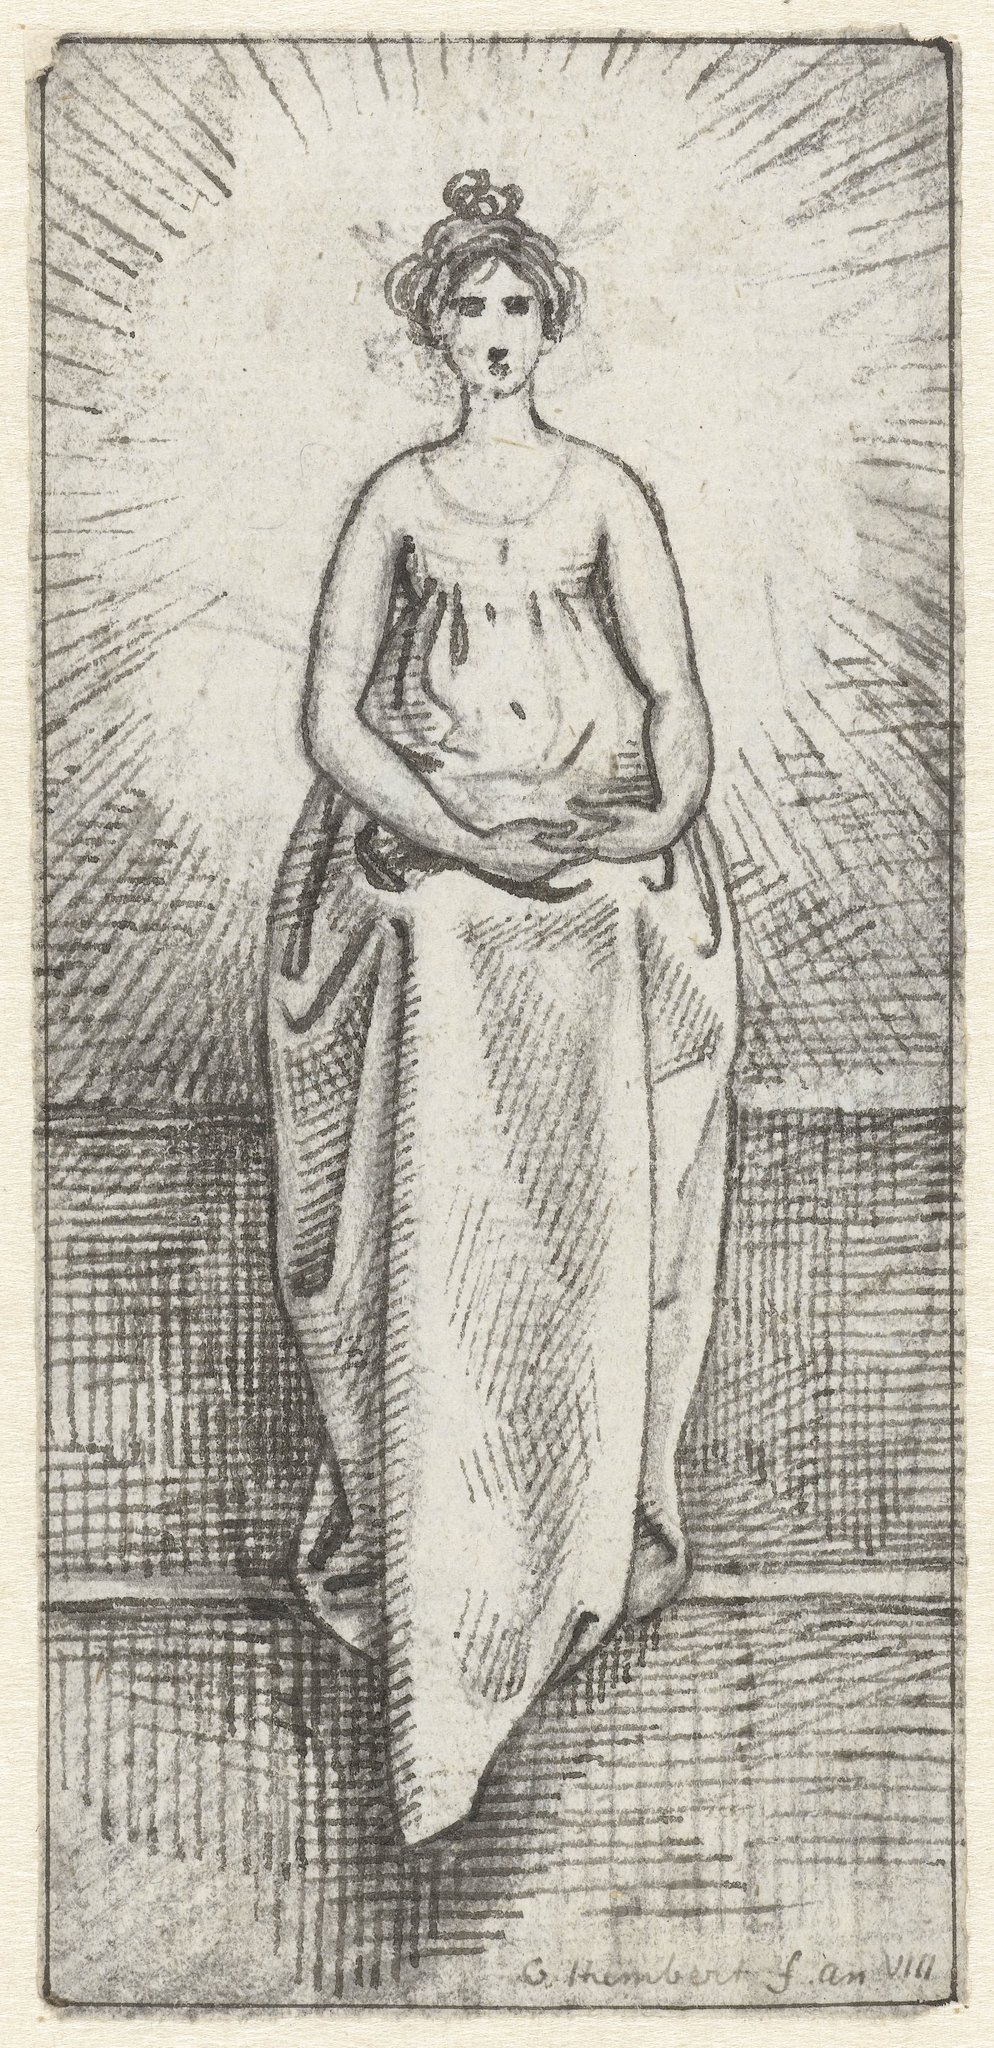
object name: drawing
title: Vrouw in stralenkrans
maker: david pièrre giottino humbert de superville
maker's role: draughtsman, painter, print maker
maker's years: 1770-1849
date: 1780-1849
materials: ink, paper, pencil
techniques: pen